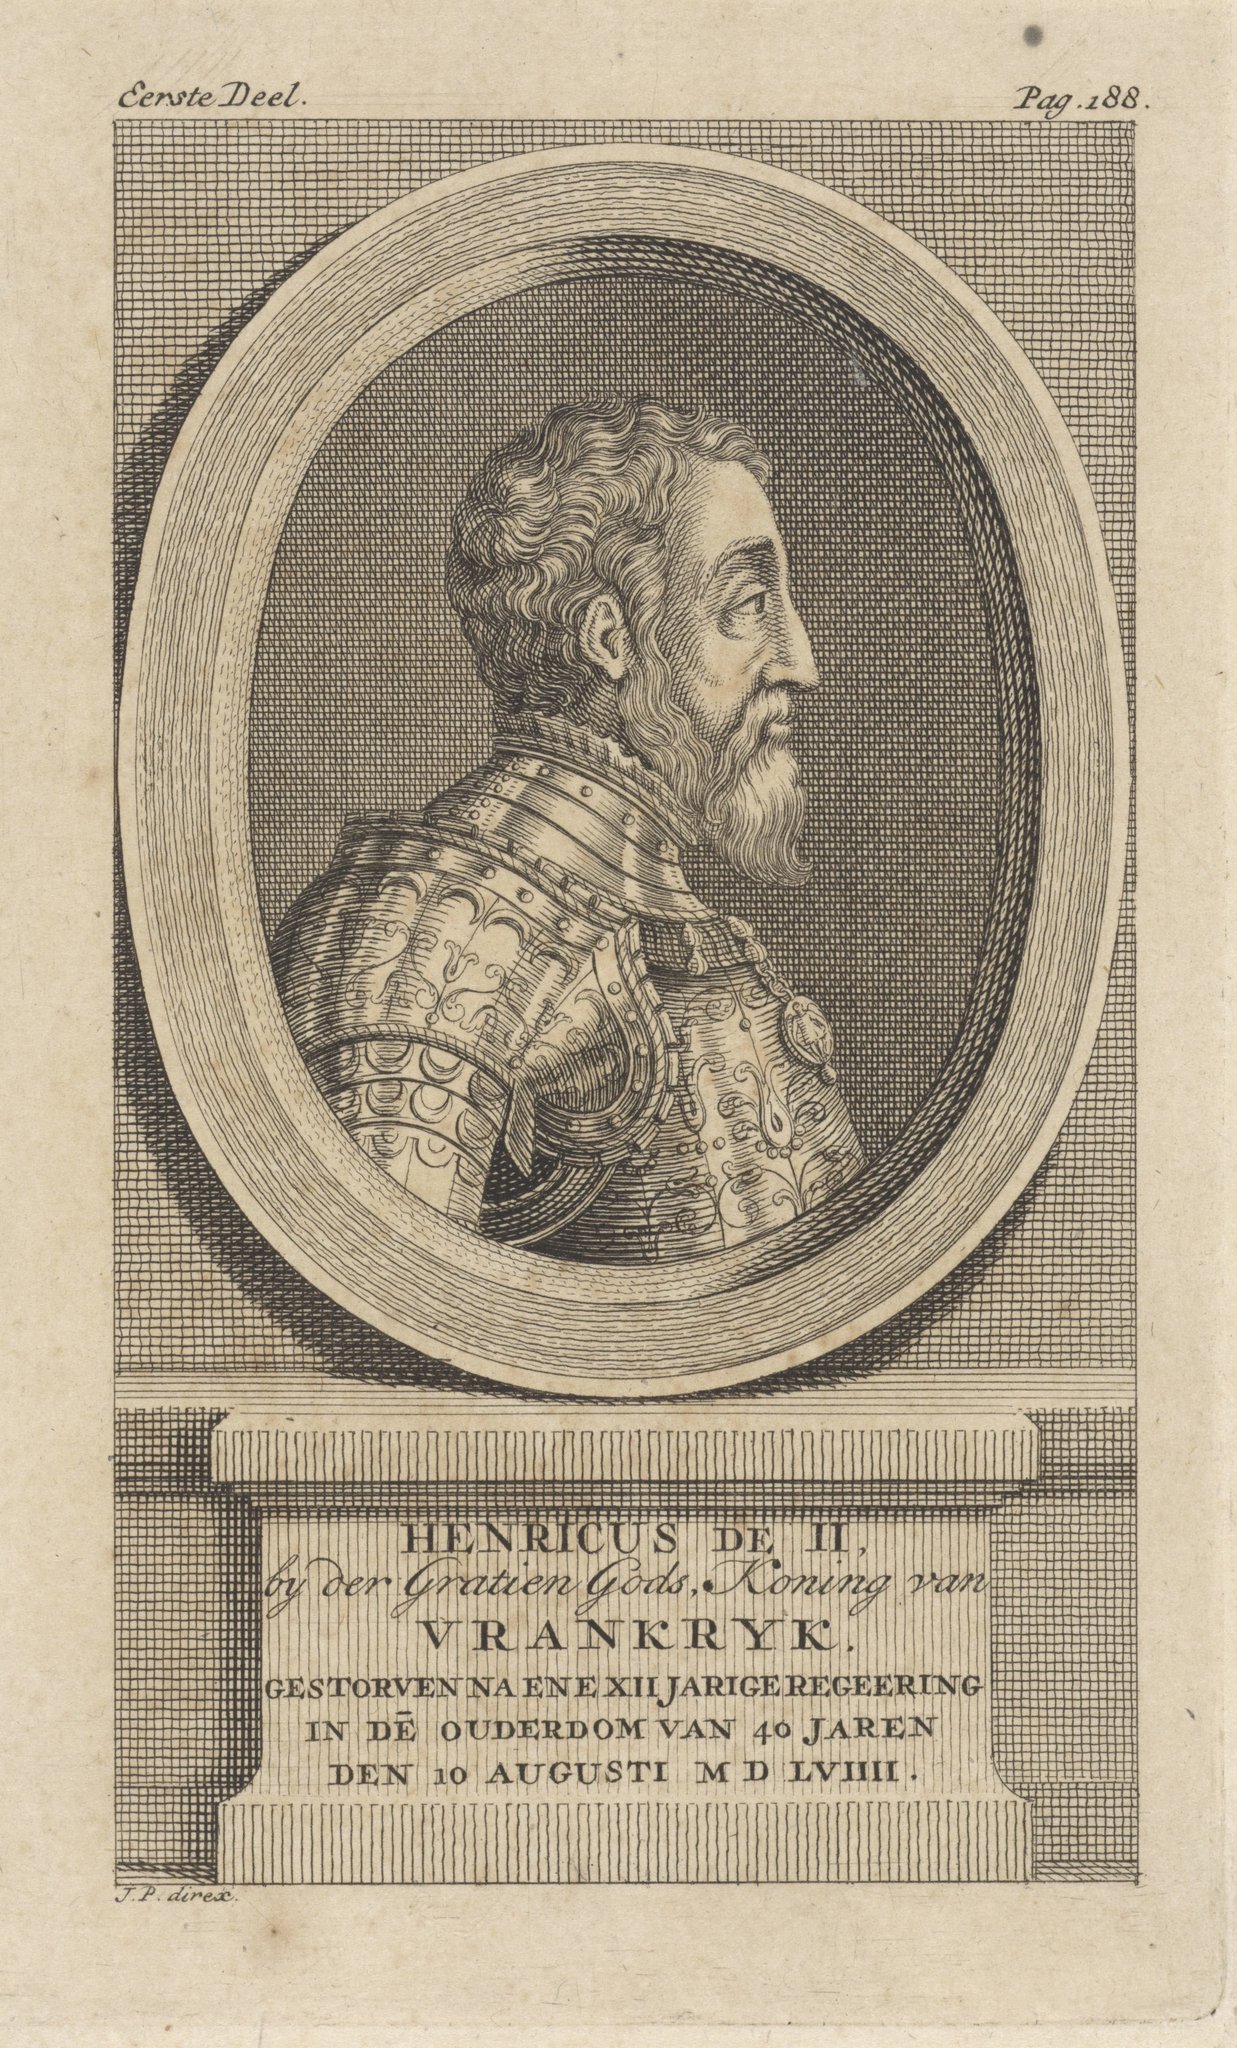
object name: print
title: Portret van Hendrik II, koning van Frankrijk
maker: jan punt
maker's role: draughtsman, print maker, publisher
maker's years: 1711-1779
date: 1748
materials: paper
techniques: engraving, etching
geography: northern netherlands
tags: paris, armour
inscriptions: collector's mark: Lugt 2228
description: Prent gebruikt als illustratie in: Meteren, Emanuel van. Historie van de oorlogen en geschiedenissen der Nederlanderen, en der zelver naburen: beginnende met den jare 1315, en eindigende met den jare 1611, deel I, p. 188. Gorinchem/Breda: Nicolaas Goetzee, Pieter Goetzee/Willem Goetzee, 1748.